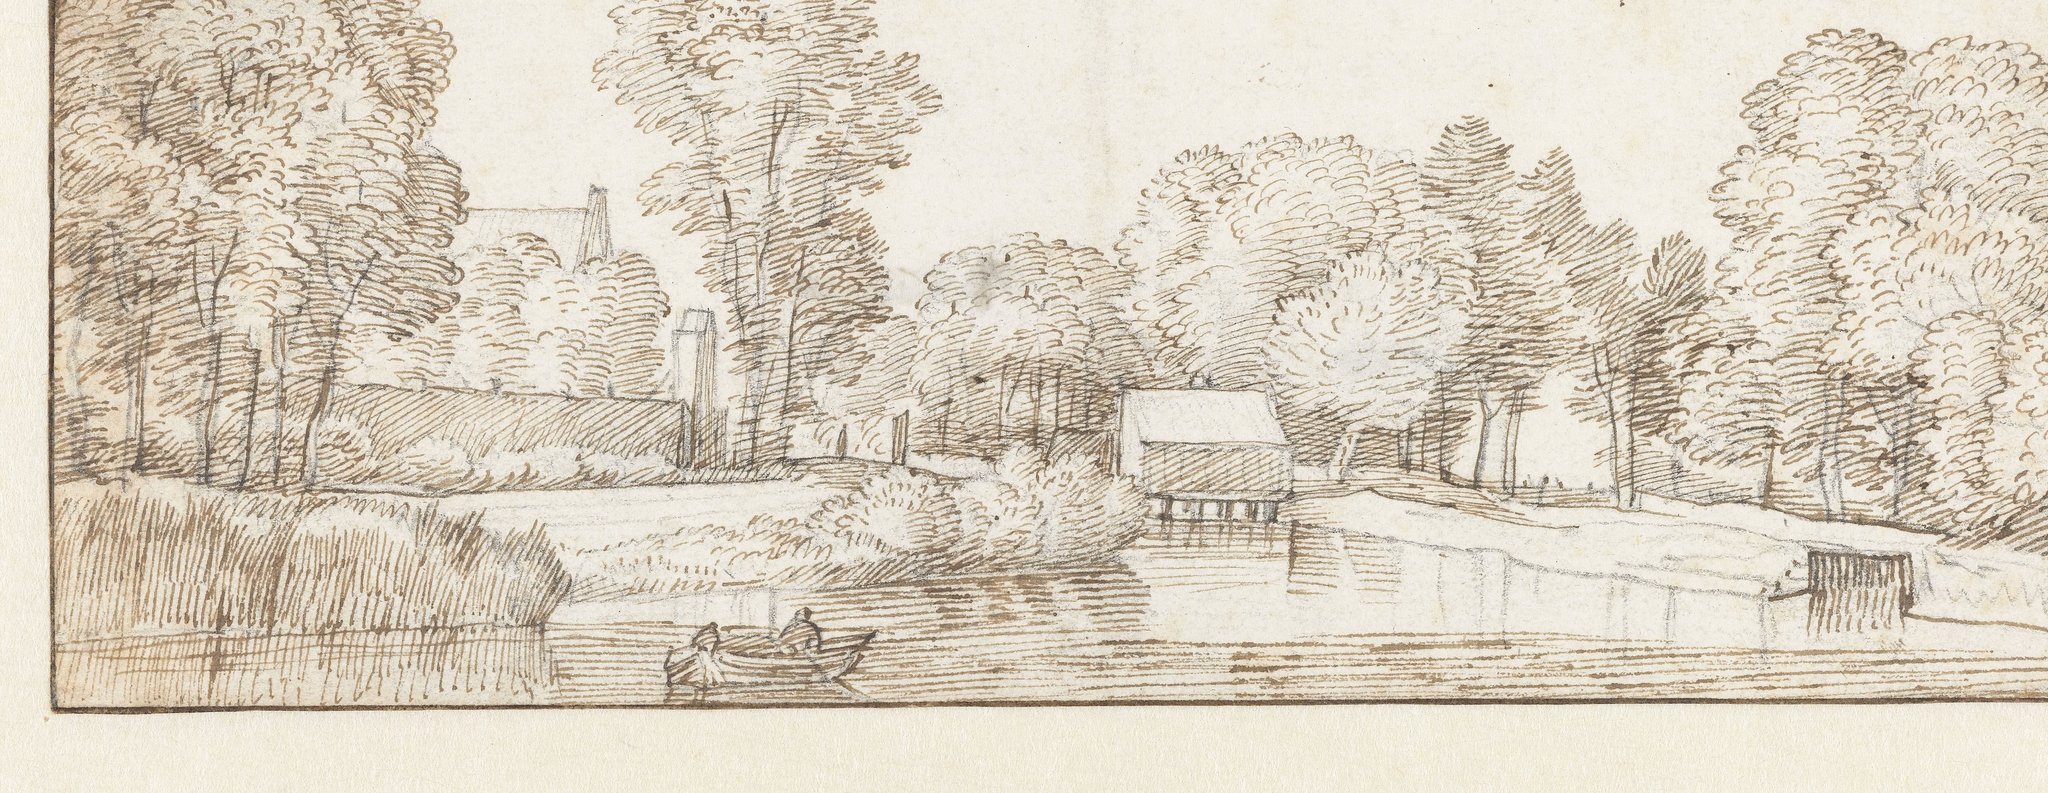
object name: drawing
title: Riviergezicht aan de Vecht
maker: jacob esselens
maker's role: draughtsman, print maker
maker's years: 1626-1687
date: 1636-1687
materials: chalk, graphite, ink, paper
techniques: pen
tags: vecht